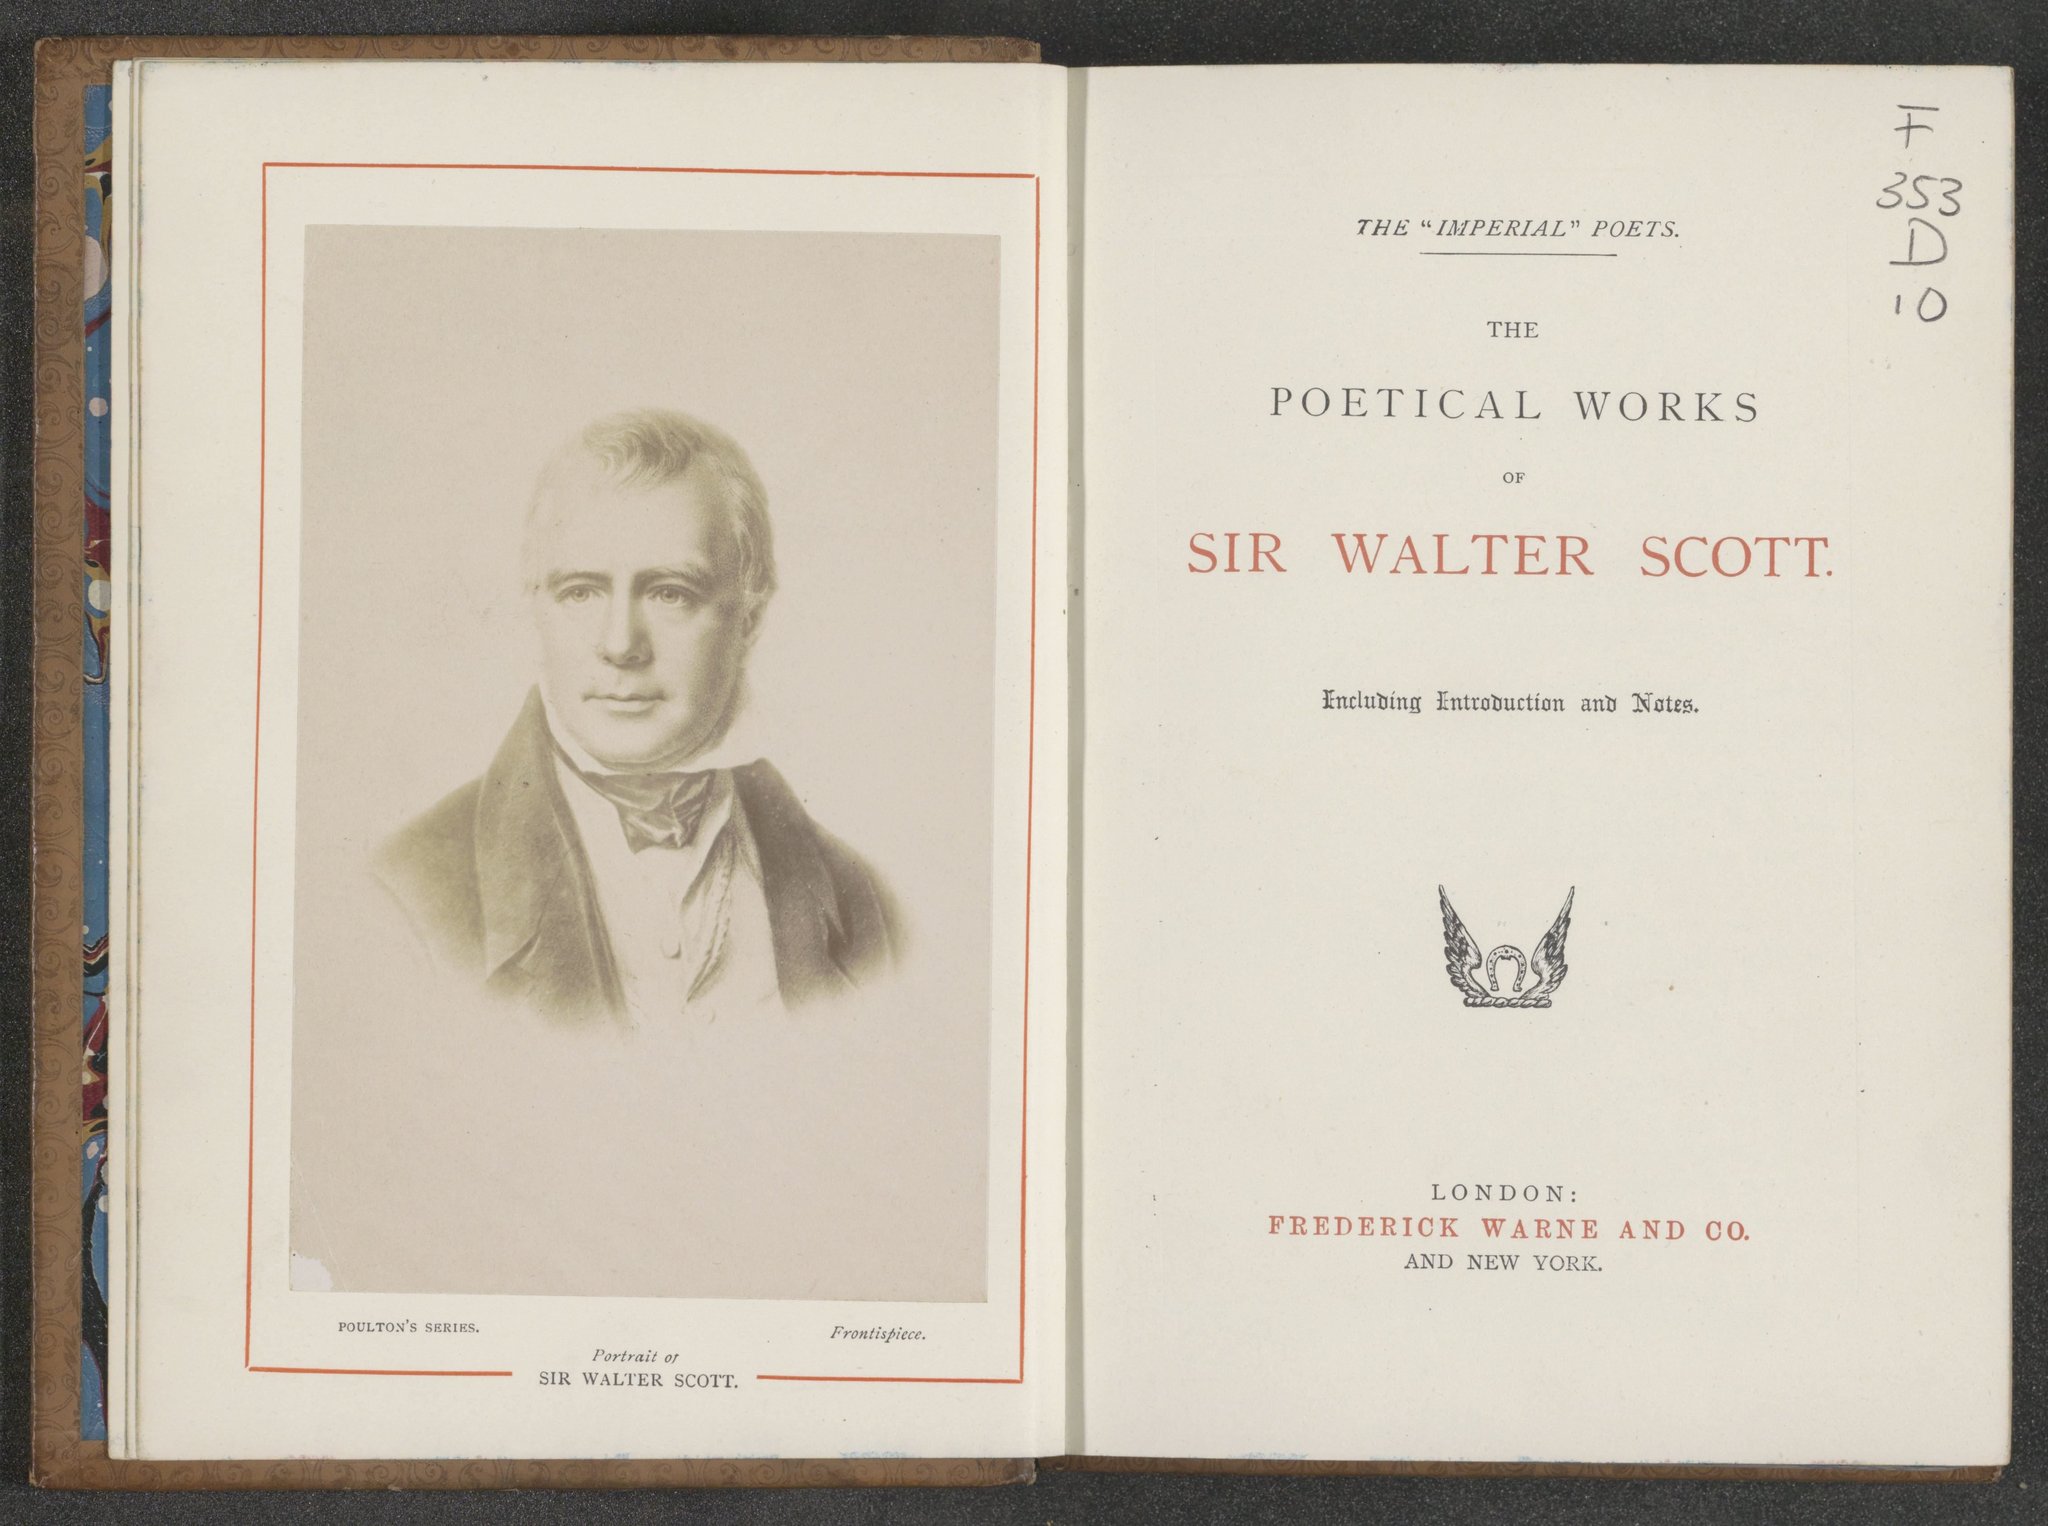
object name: book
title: The poetical works of Sir Walter Scott including introduction and notes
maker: walter scott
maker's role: dichter, schrijver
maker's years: 1771-1832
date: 1890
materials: leather, paper, photographic support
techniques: albumen print, marbling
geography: london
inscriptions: inscription: ‘Third Form Prise for general work Louie gertrude Parreti Luley 1900 [...]’